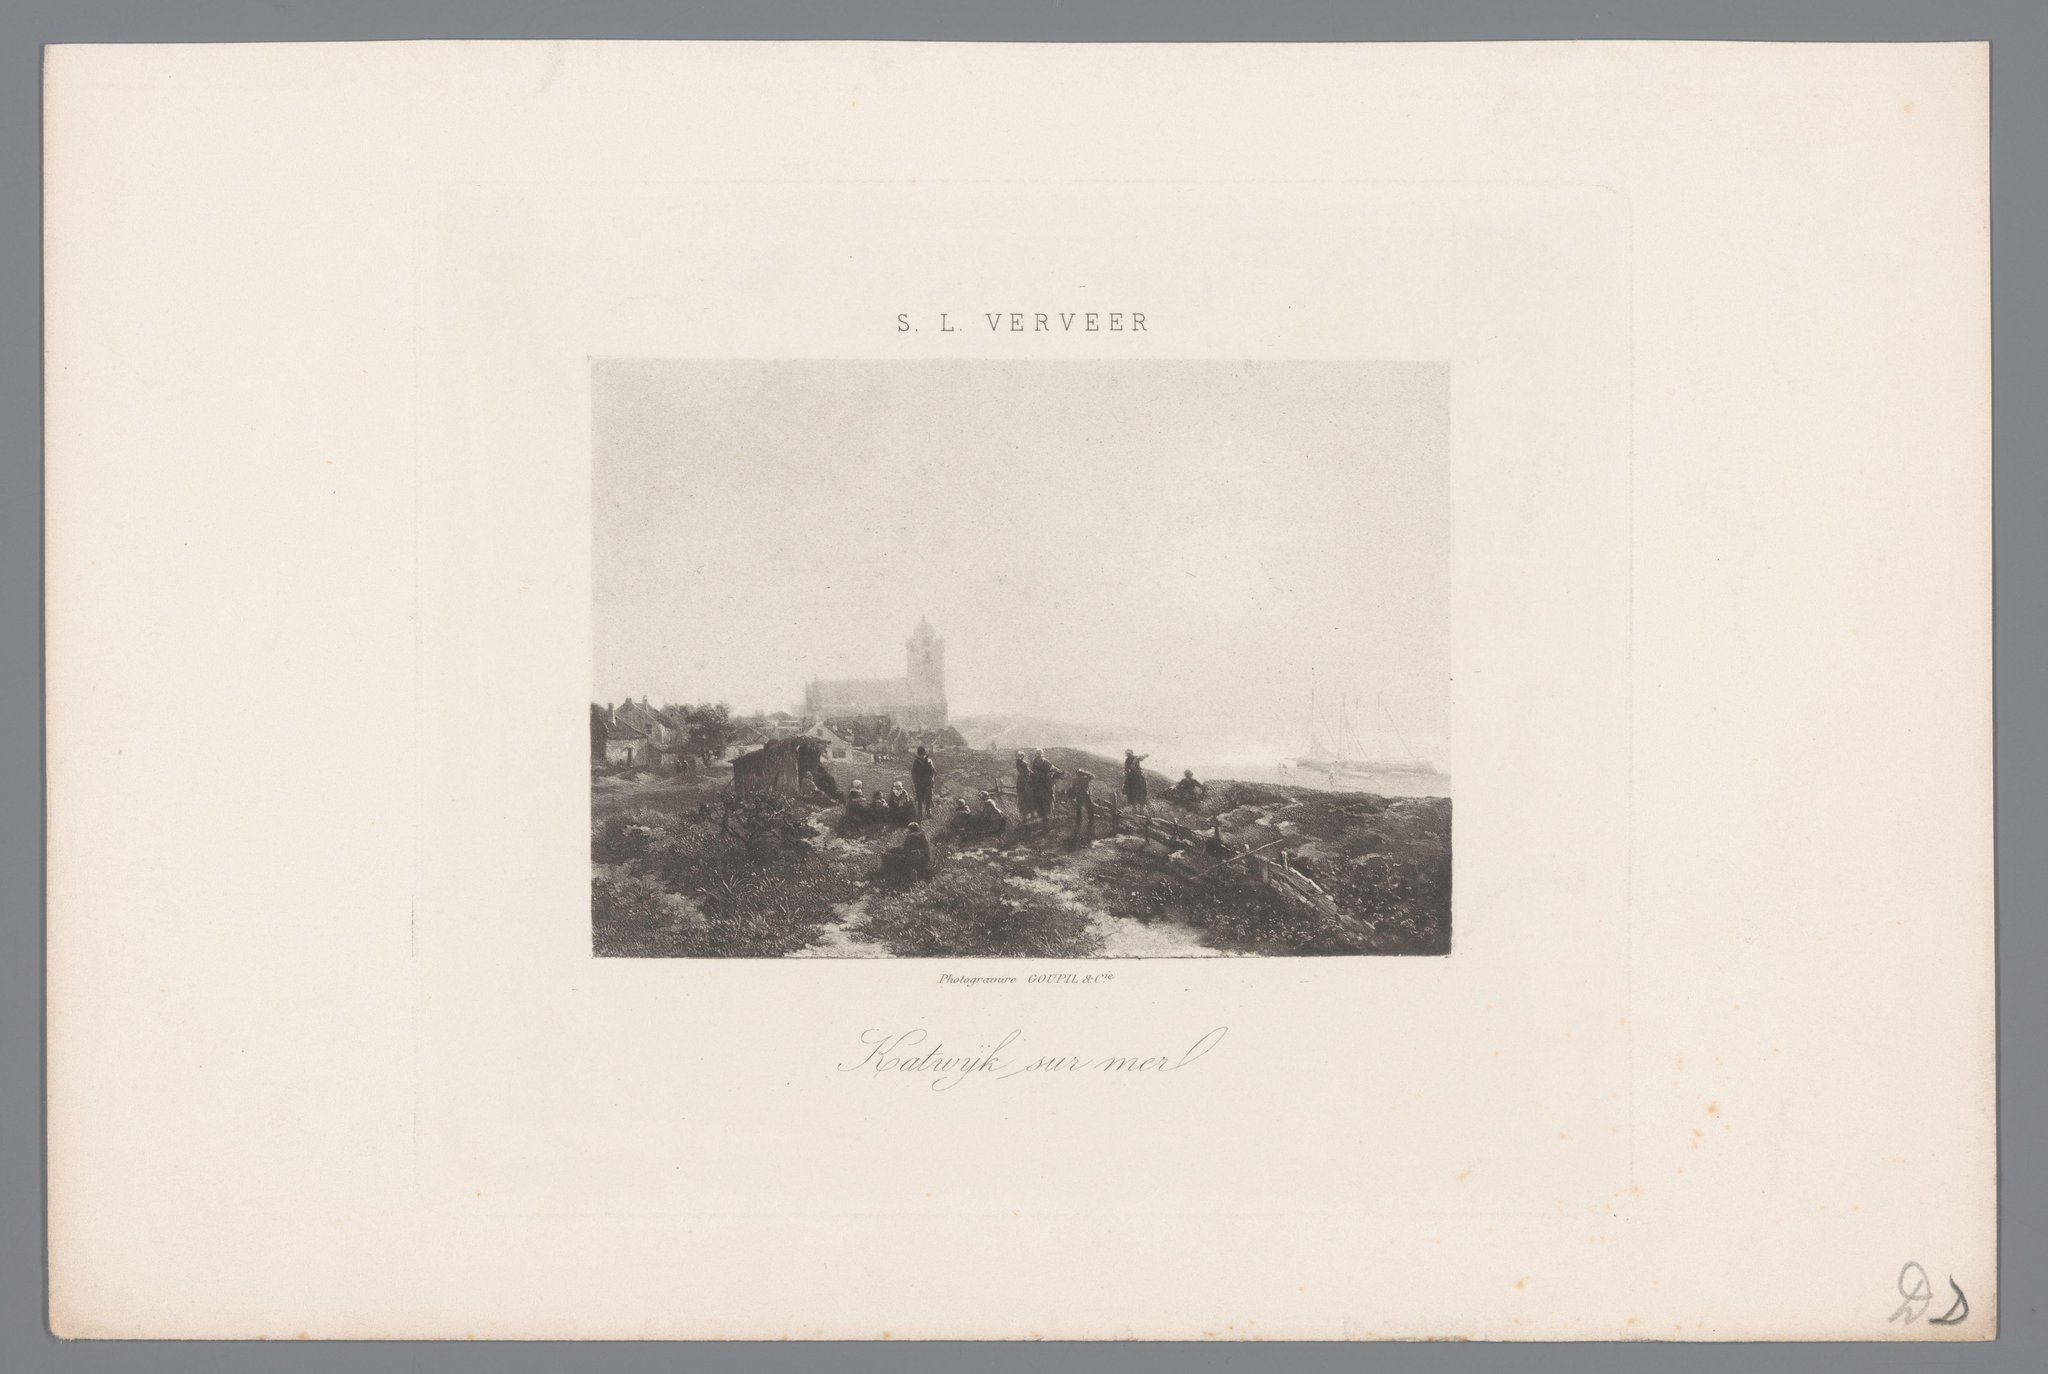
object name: photomechanical print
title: Katwijk sur mer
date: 1863-1884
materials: paper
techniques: photoaquatint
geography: paris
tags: coast (+ landscape with figures, staffage)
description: Afdruk naar het schilderij 'Namiddag te Katwijk aan Zee' (1863) door Salomon Leonardus Verveer.